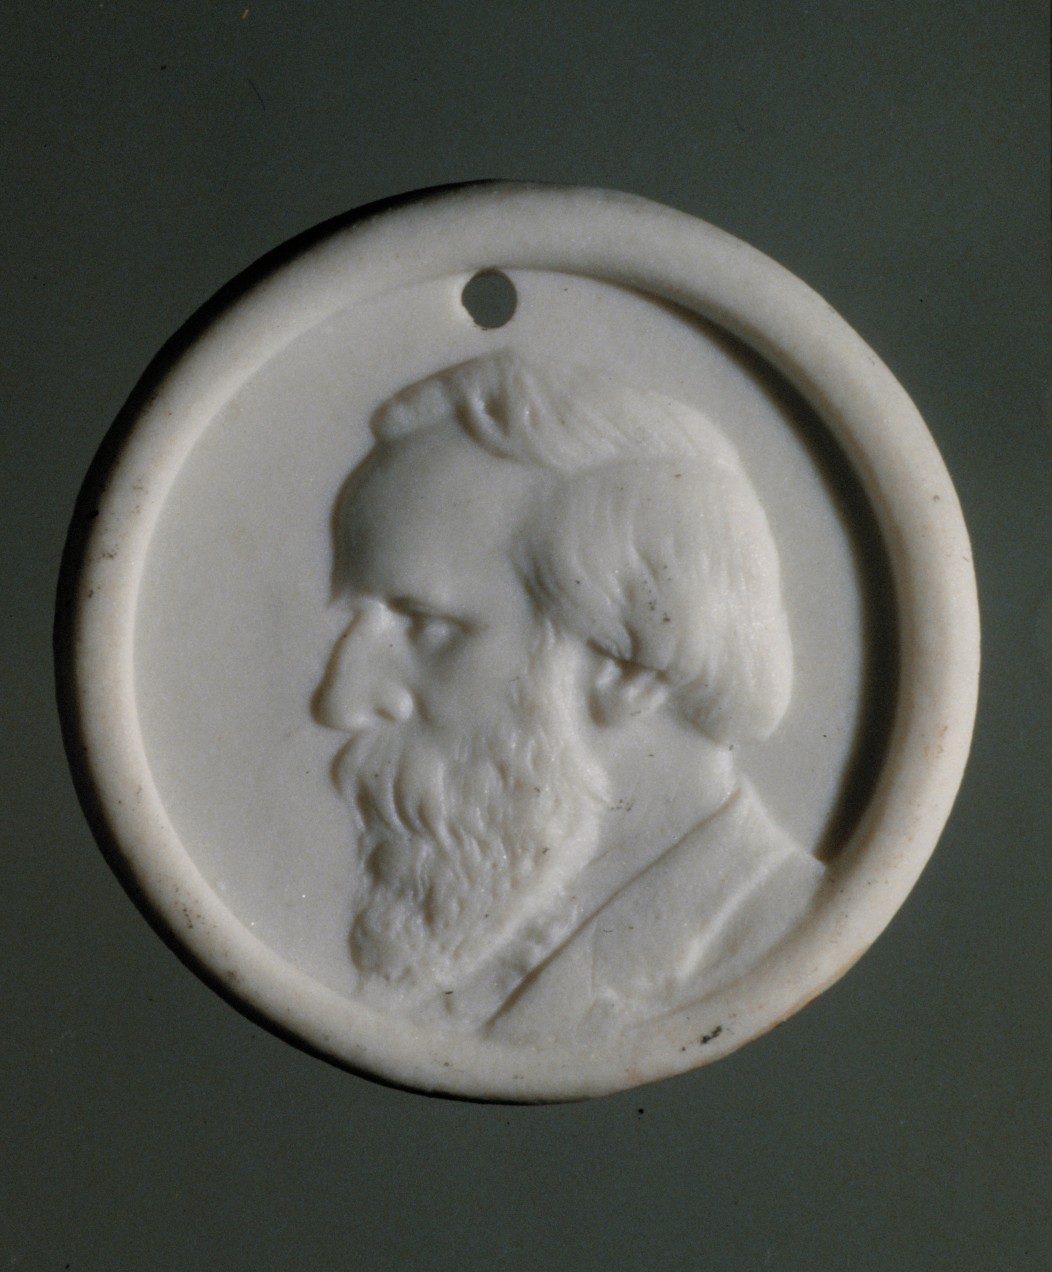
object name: campaign button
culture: american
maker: union porcelain works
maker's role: maker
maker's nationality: american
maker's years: 1863-1922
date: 1876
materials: porcelain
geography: united states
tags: men,profiles